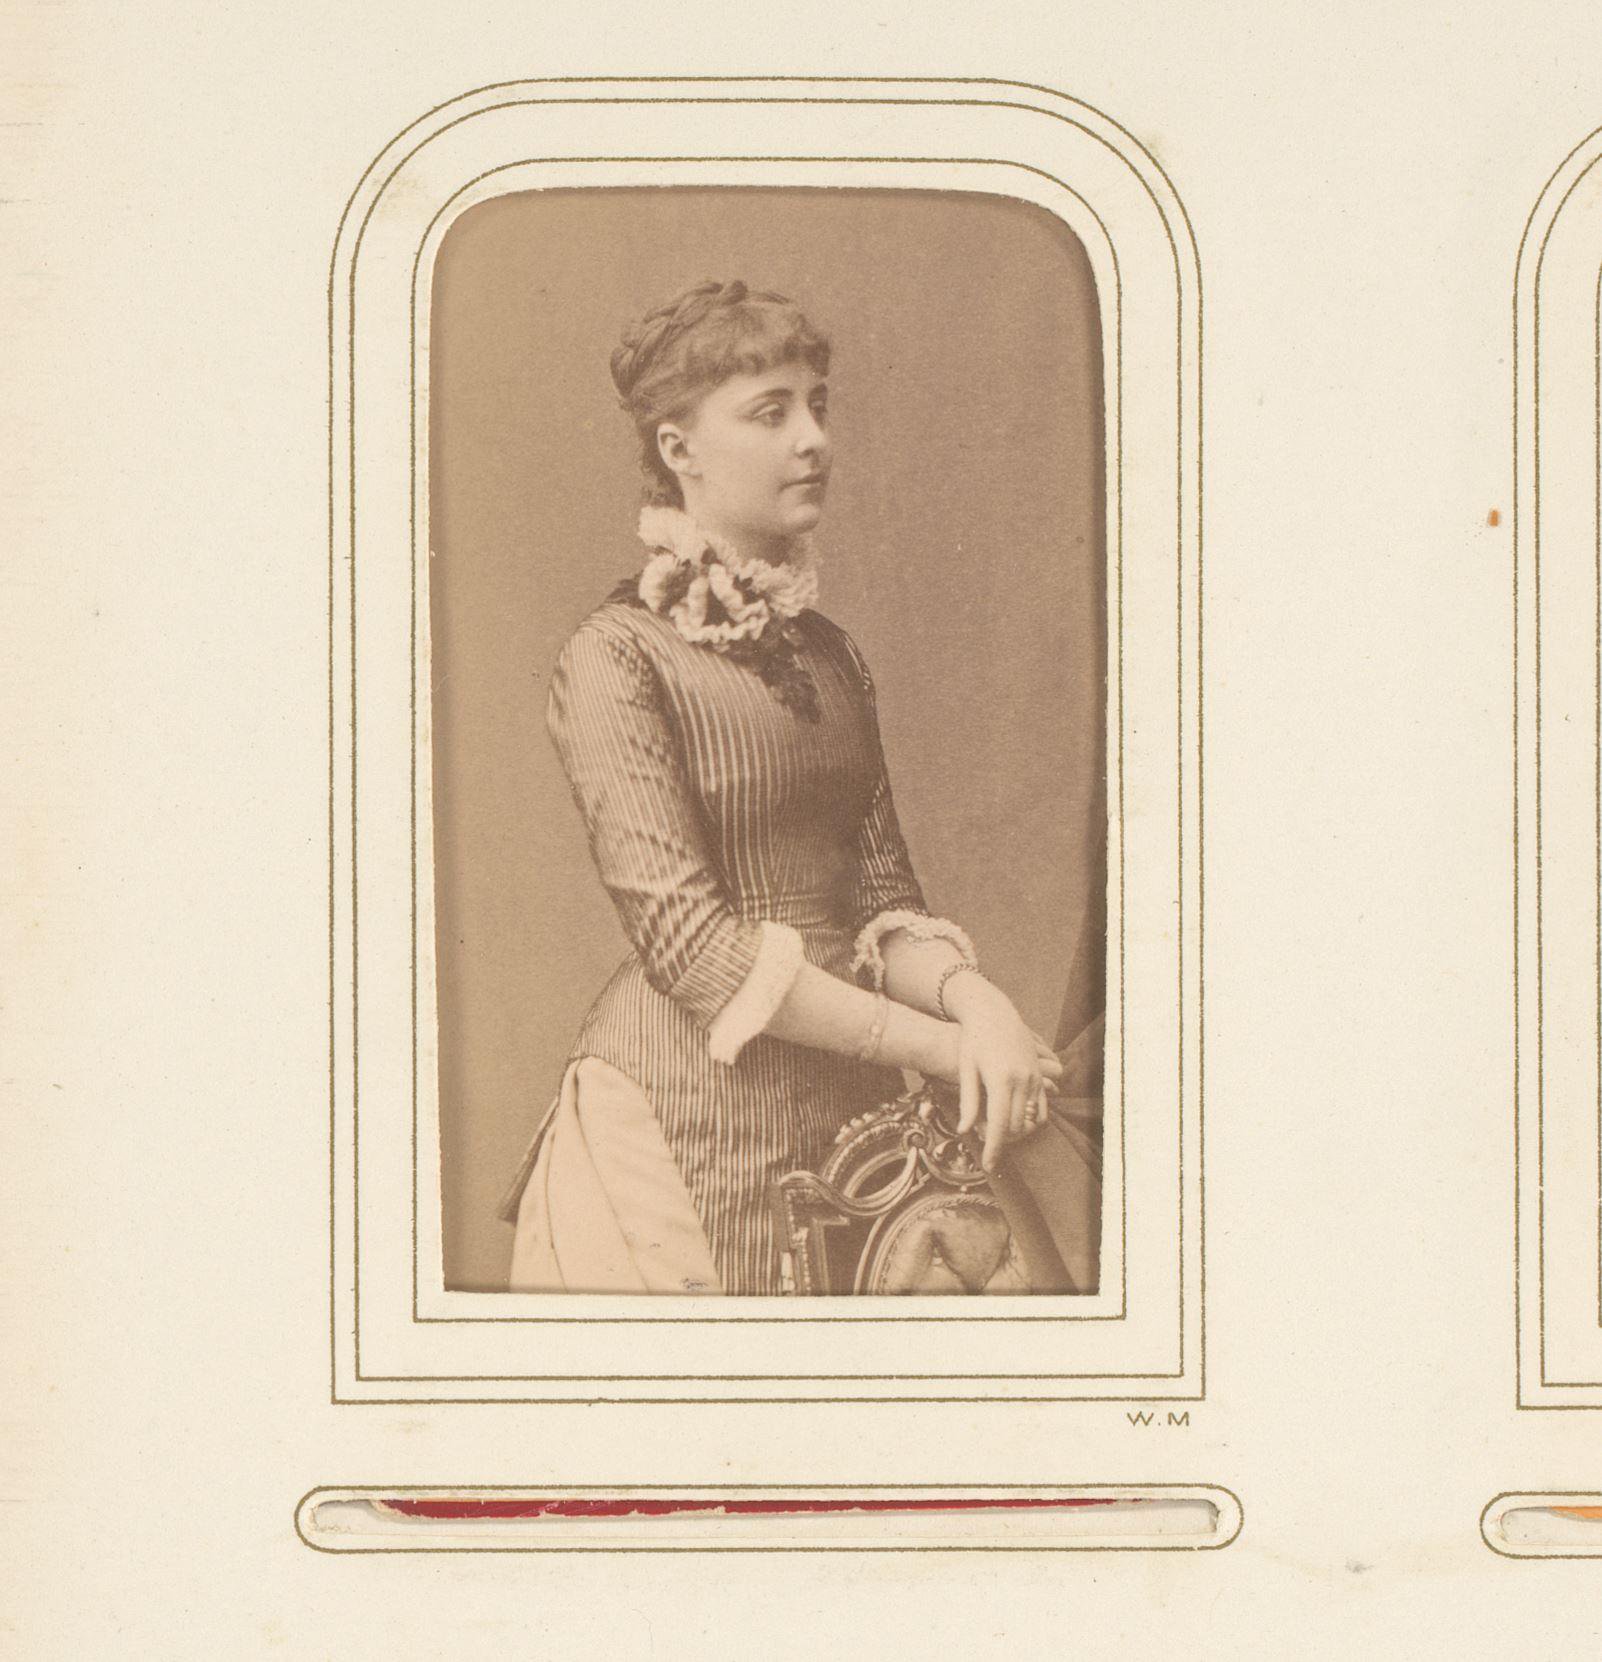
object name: album leaf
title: Portret van Ellen Hartman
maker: gösta florman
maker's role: fotograaf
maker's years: 1831-1900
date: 1880-1890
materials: cardboard, photographic support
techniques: albumen print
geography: stockholm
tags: historical persons - bb - woman, portrait of actor, actress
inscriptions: inscription: ‘Gösta Florman/ STOCKHOLM/ 28A Regeringsgatan 28 A.’, annotation: ‘Ellen Hartman - Cedeström/ b. Hedlund/ 1860 - 1945’